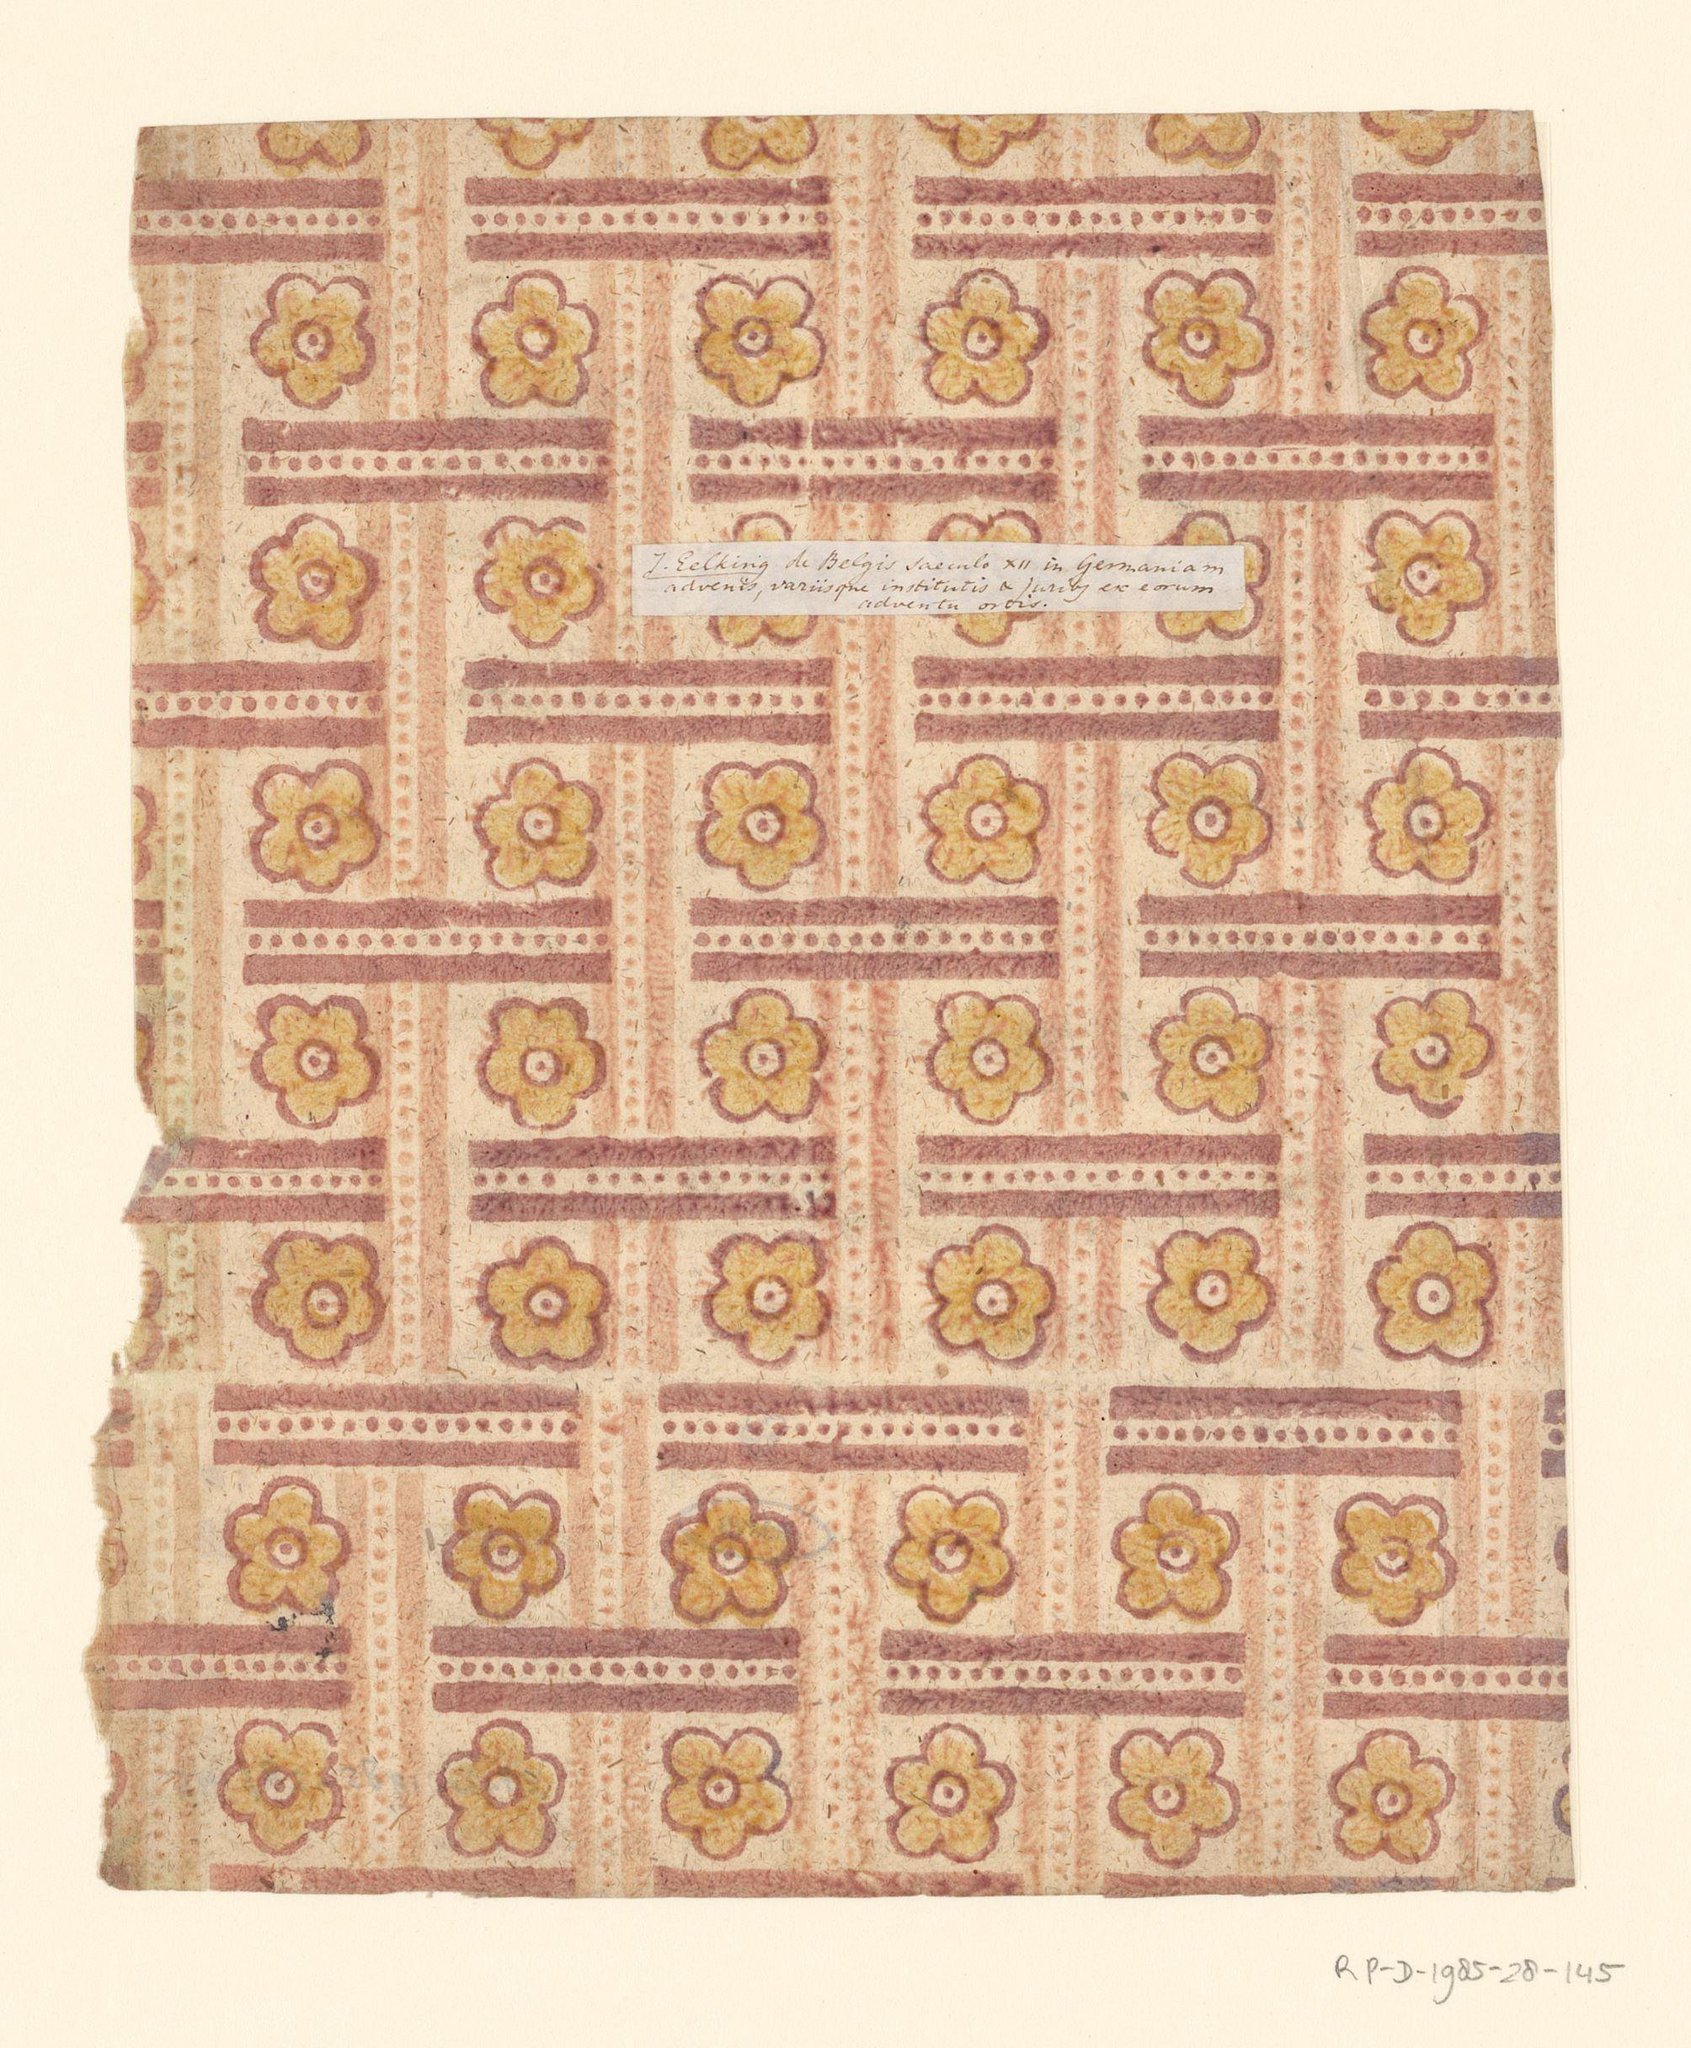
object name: printed paper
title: Blad met strooipatroon van bloemmotief tussen gevlochten lijnen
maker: Anonymous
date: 1750-1900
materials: paper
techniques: printing block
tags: ornament derived from plant forms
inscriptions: collector's mark: Lugt 2228, collector's mark: Lugt 2760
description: Blad met strooipatroon van bloemmotief tussen gevlochten lijnen. Met etiket met opschrift: 'J. Eelking ... ordis.' Helft van een omslag.